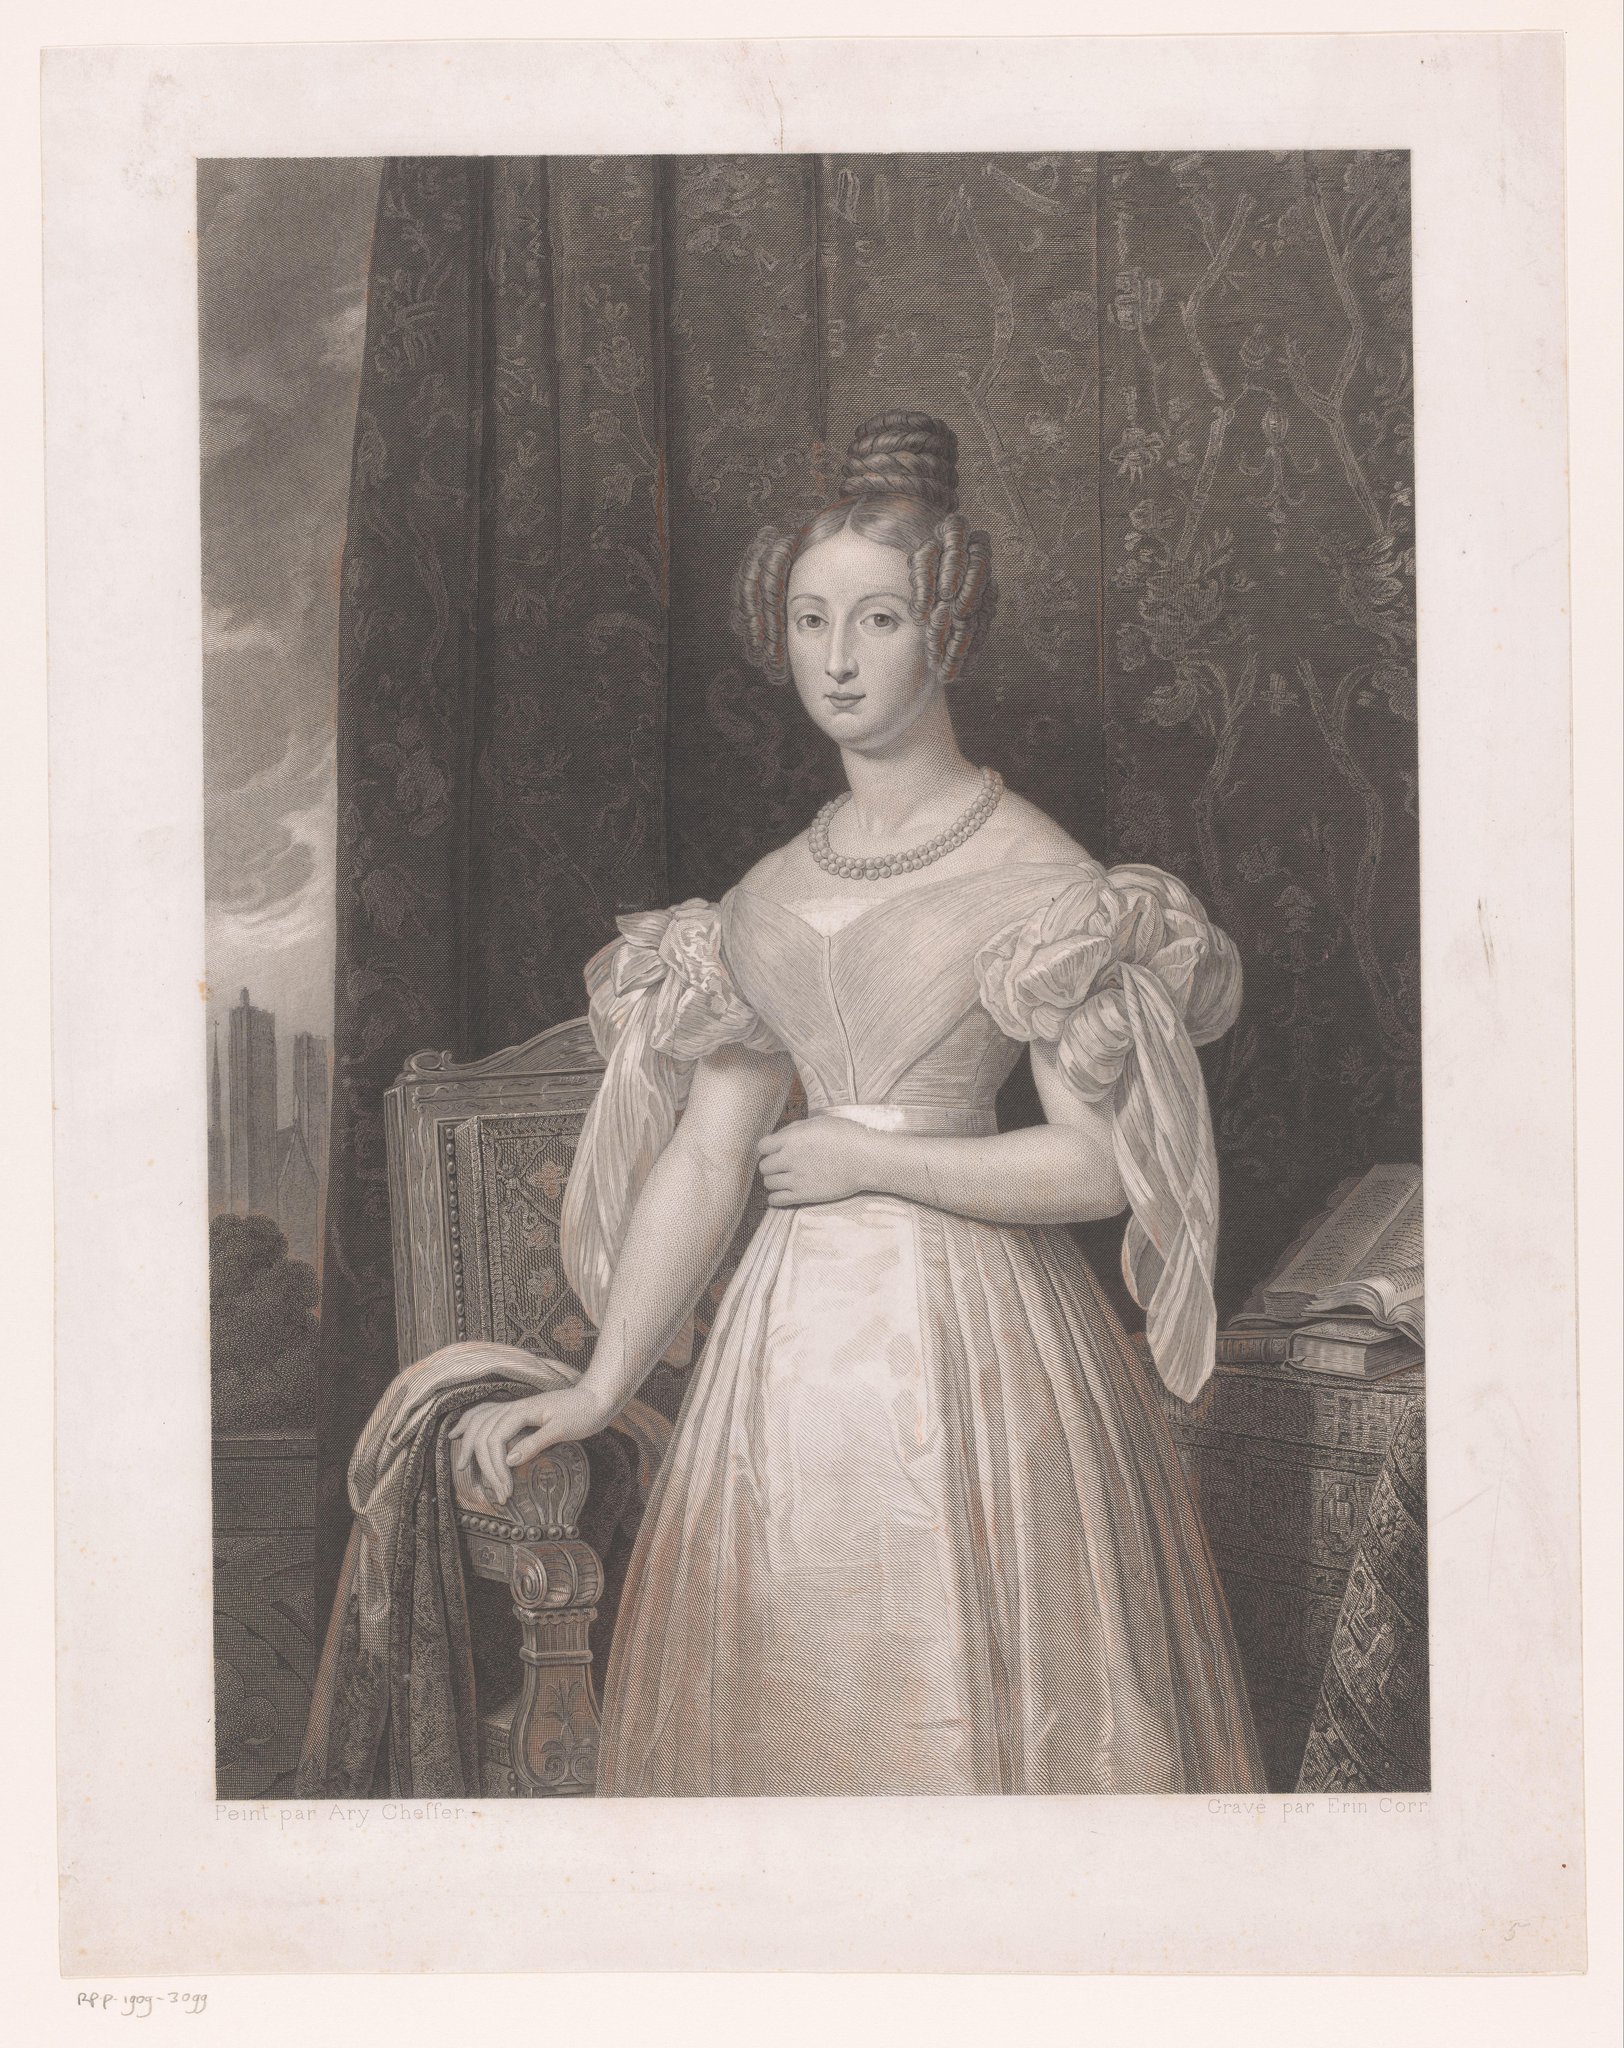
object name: print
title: Portret van Louise Marie van Orléans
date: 1832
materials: paper, pastel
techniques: engraving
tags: louise marie van orléans (koningin van belgië), historical persons, standing figure - aa - female human figure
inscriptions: collector's mark: Lugt 2228